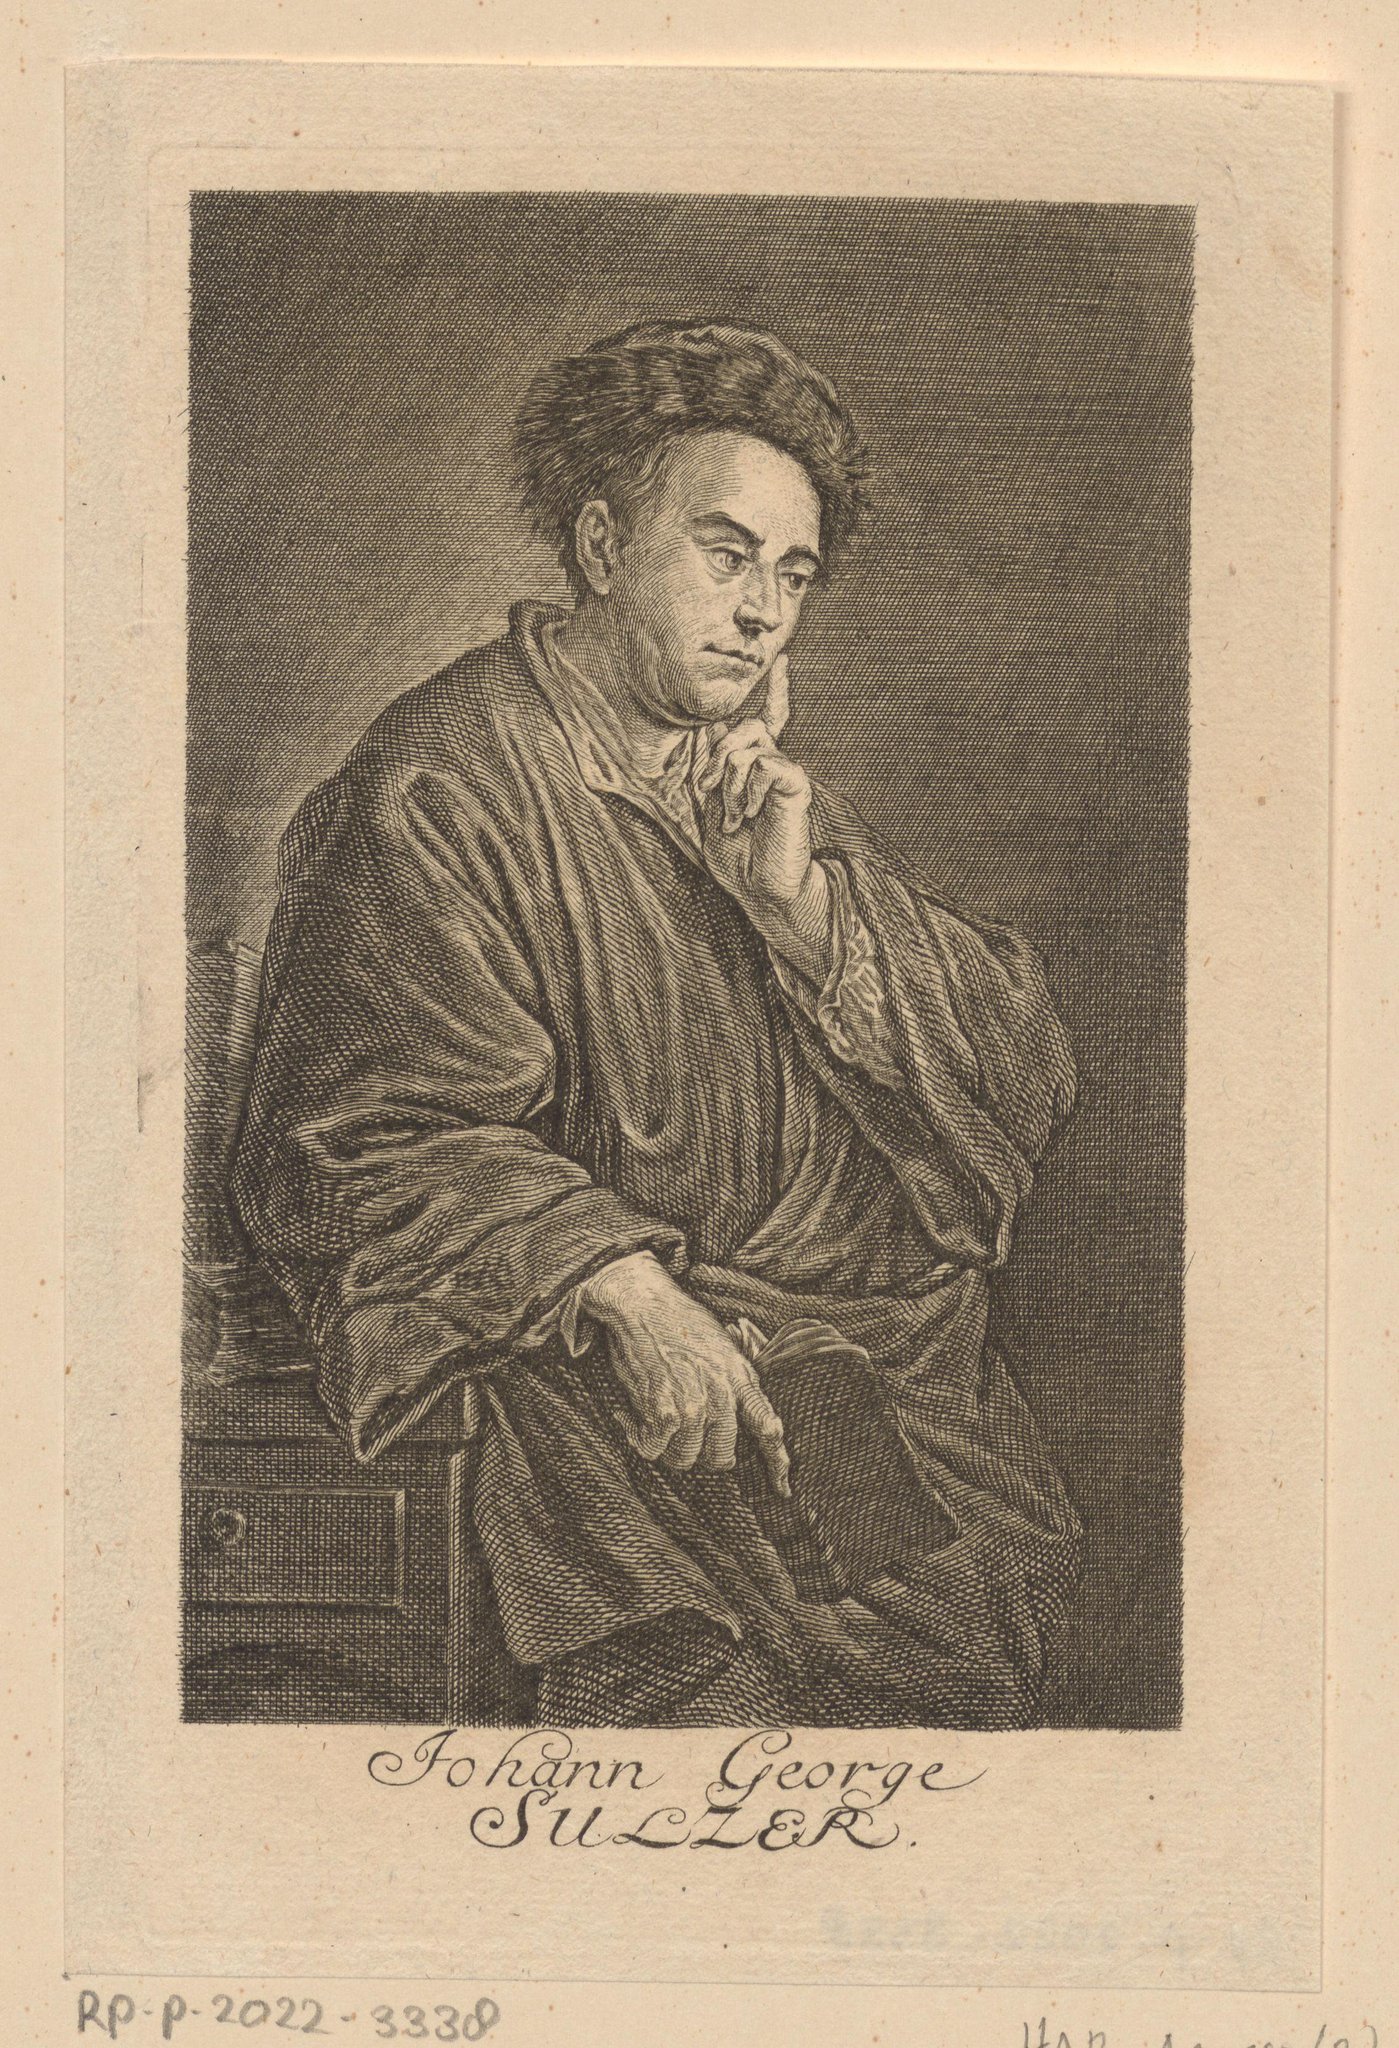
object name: print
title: Portret van Johann Georg Sulzer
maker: friedrich johann kauke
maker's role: print maker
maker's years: -1777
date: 1760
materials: paper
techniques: engraving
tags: berlin, scholar, philosopher, historical persons, book - mm - book open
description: Prent mogelijk uit: Sammlung vermischter Schriften zur Beförderung der schönen Wissenschaften und der freyen Künste. Dritter Band, erstes Stück. Berlijn: Friedrich Nicolai, 1760.